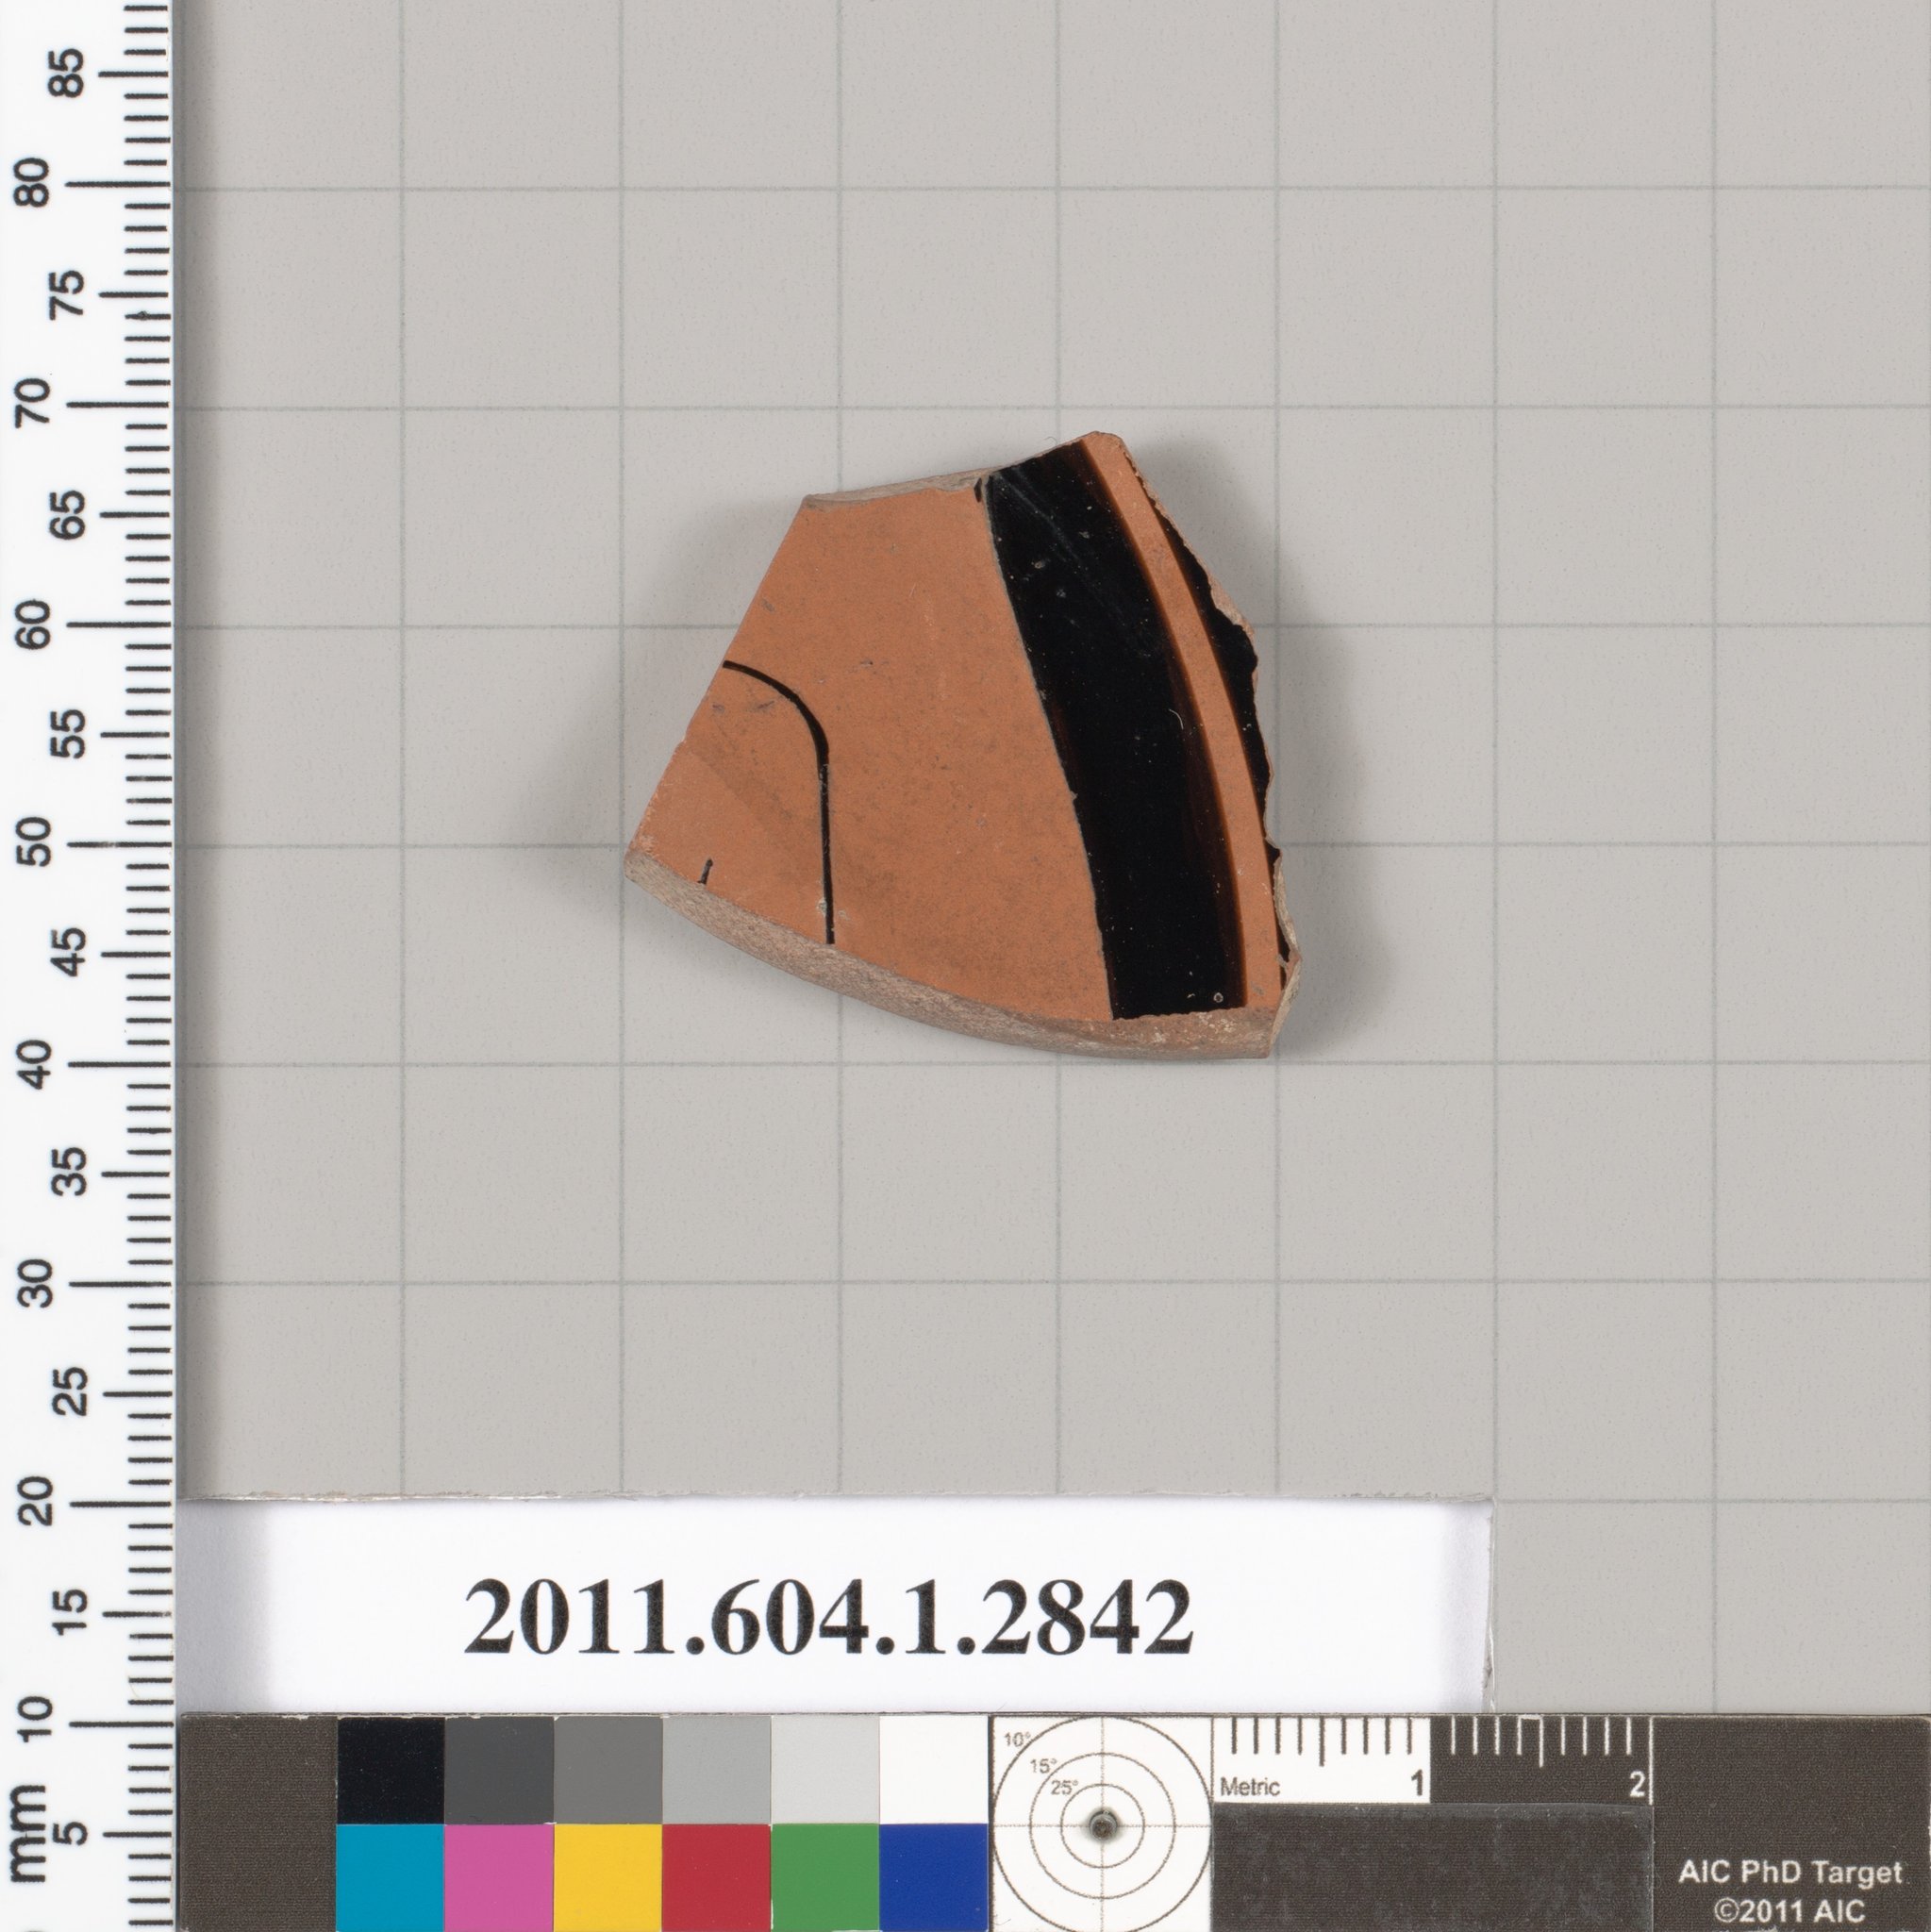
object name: kylix fragment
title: Terracotta fragment of a kylix (drinking cup)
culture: greek, attic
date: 500-451 BCE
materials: terracotta